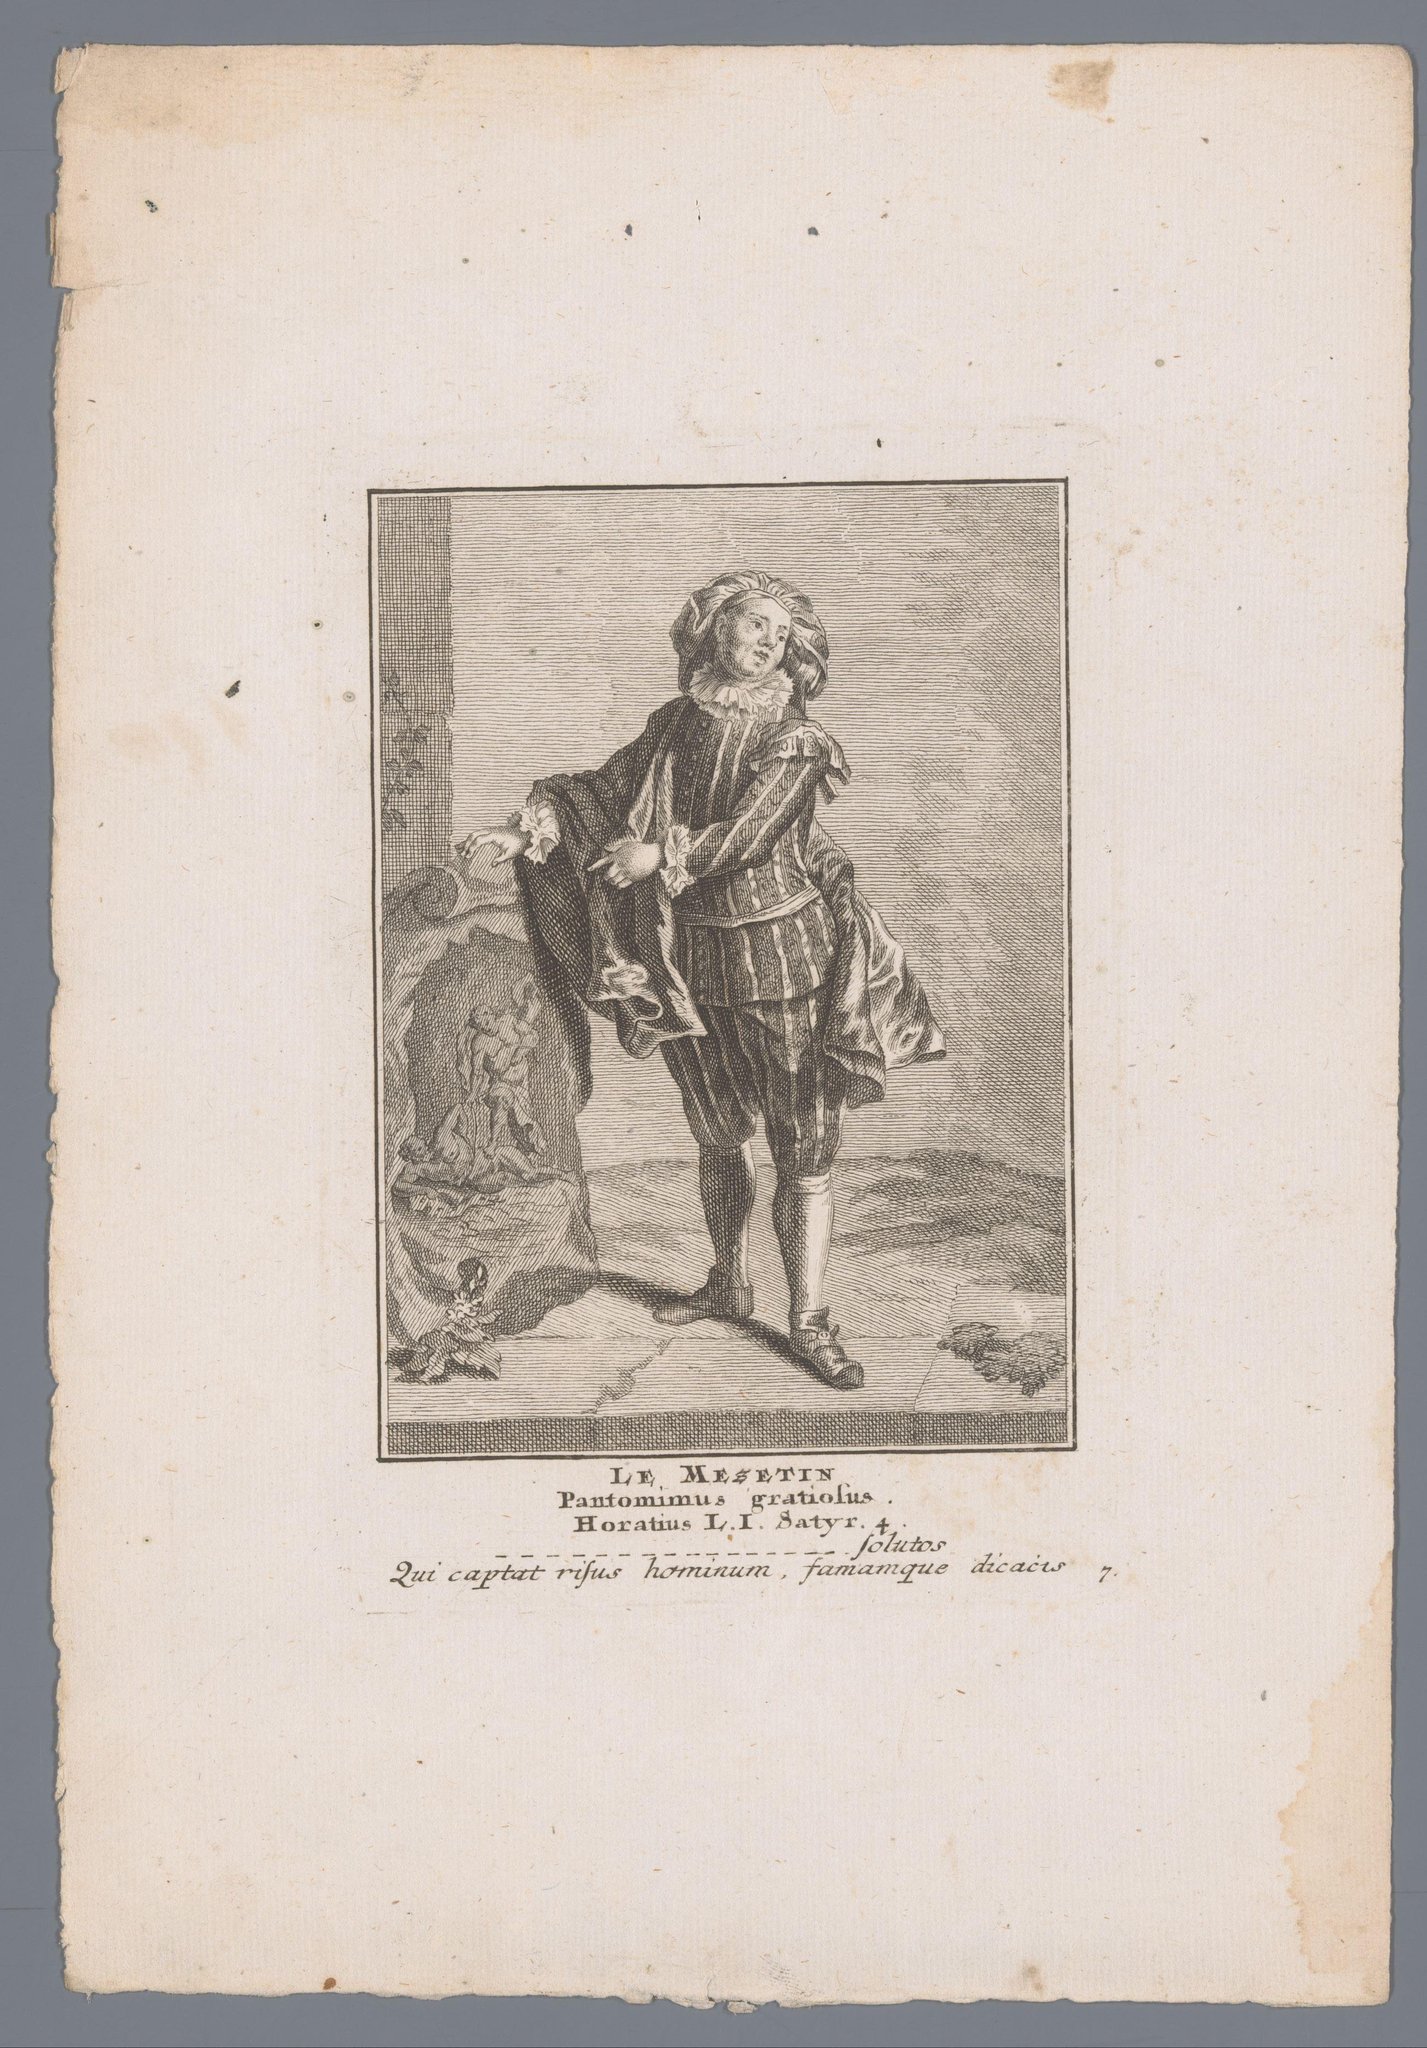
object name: print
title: Bande der Italienischen Comoedianten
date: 1694-1725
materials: paper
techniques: etching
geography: germany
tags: types in 'commedia dell'arte', group of actors, troupe; actors on the stage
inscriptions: collector's mark: Lugt 2228